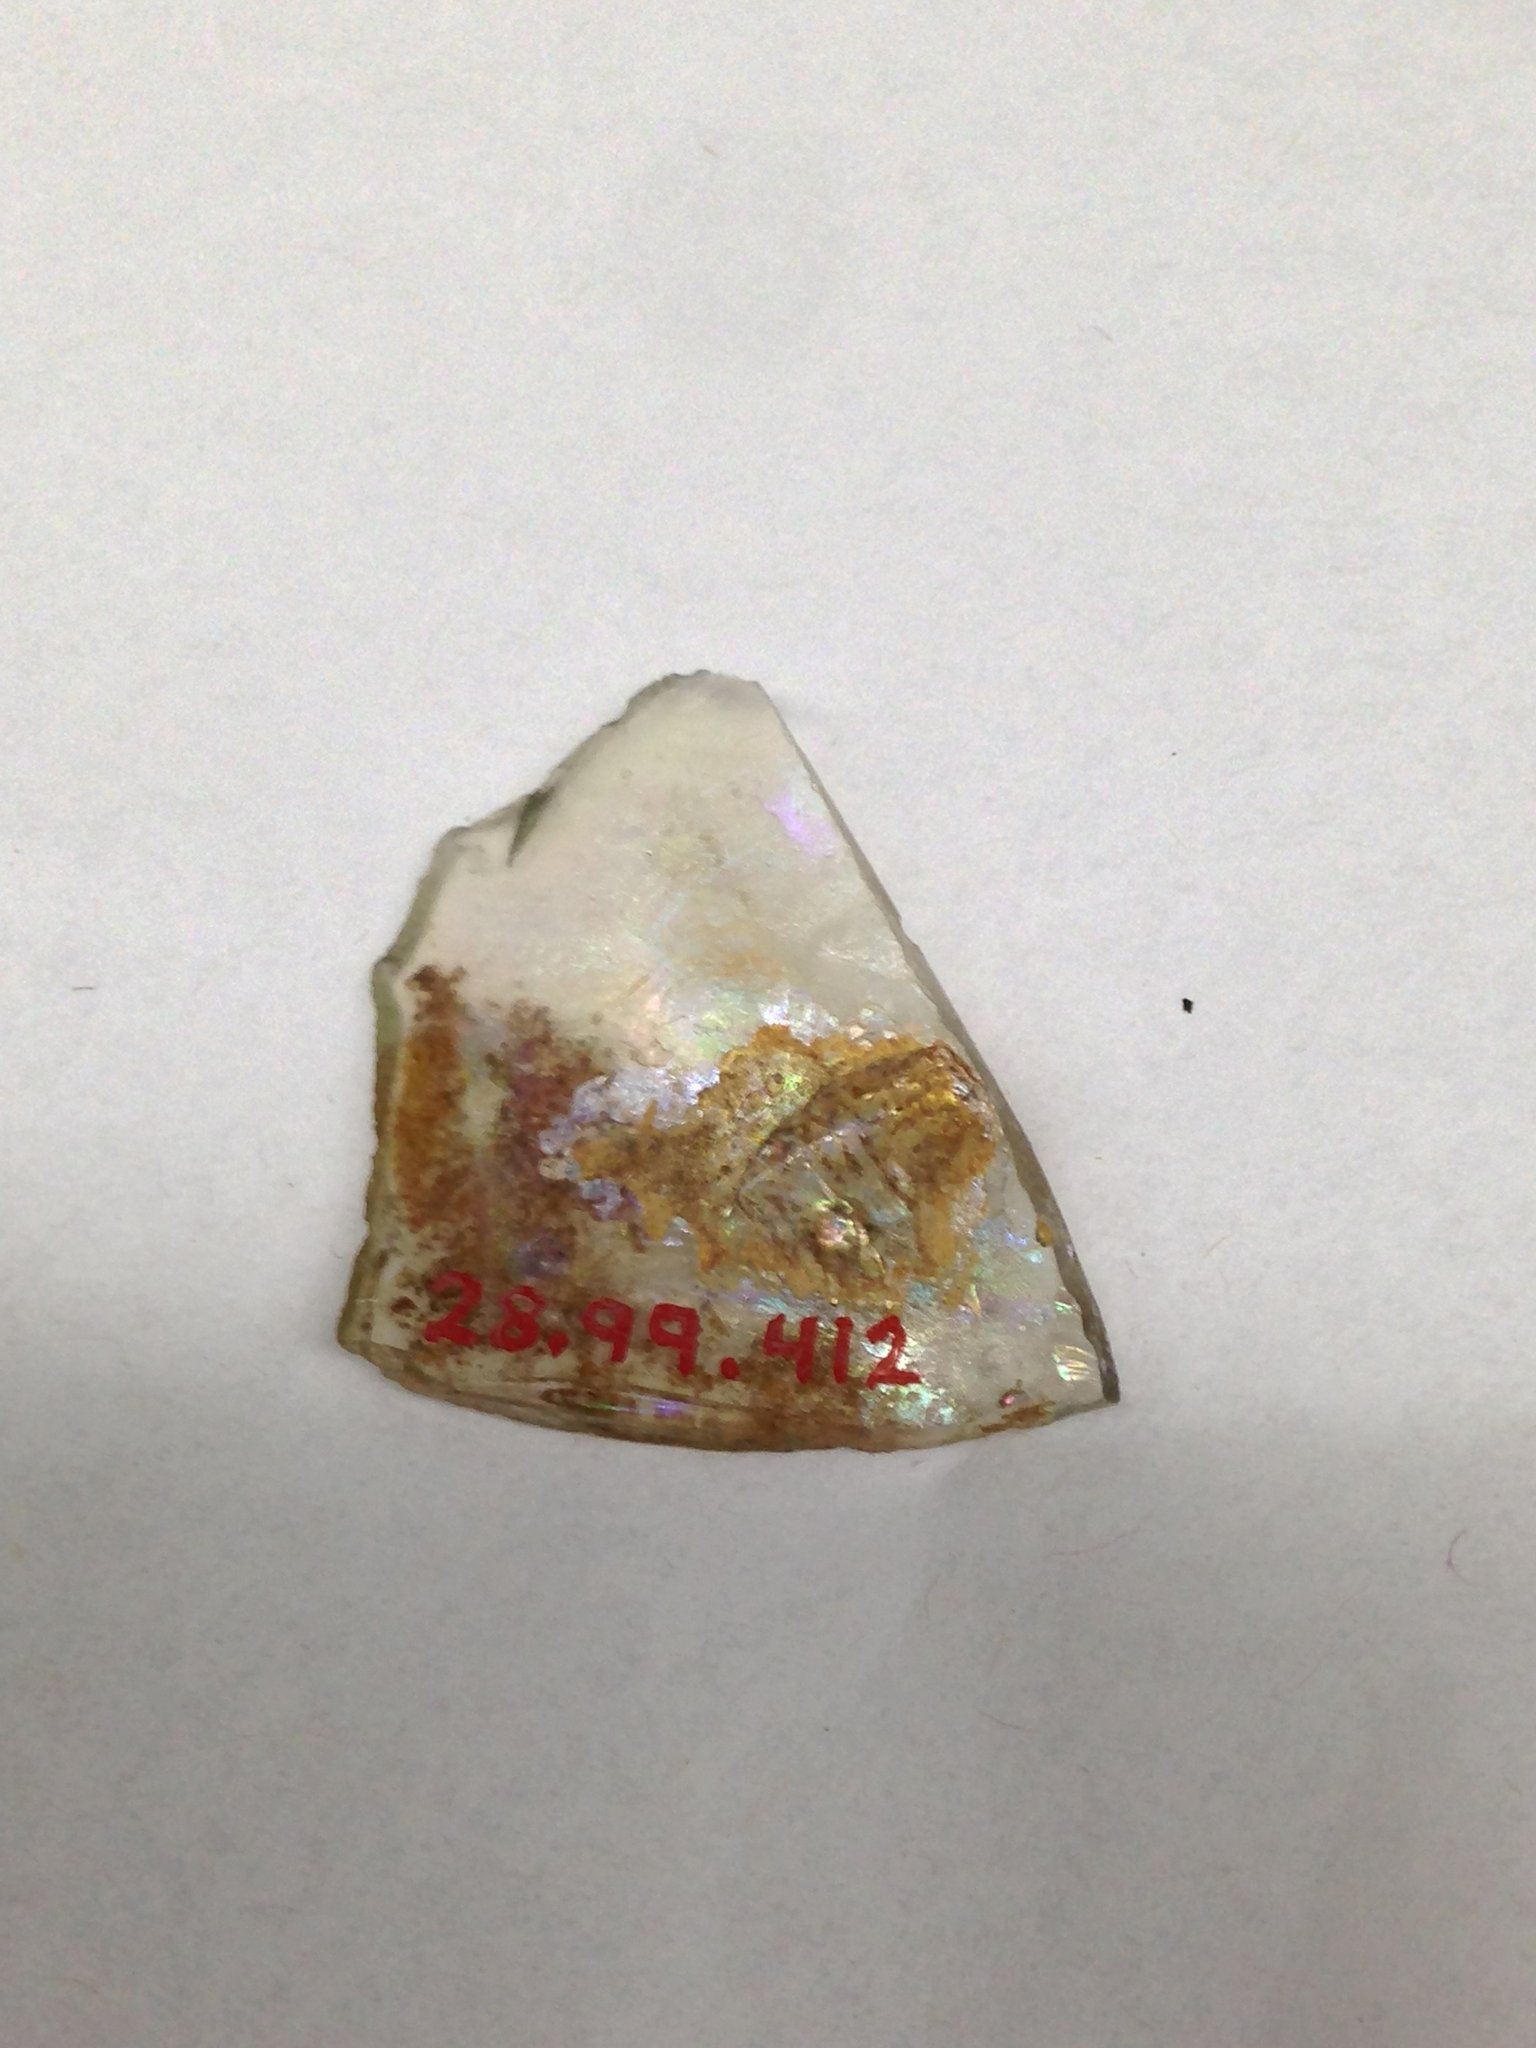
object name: fragment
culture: european or middle eastern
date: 1150-1250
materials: ceramic, glass